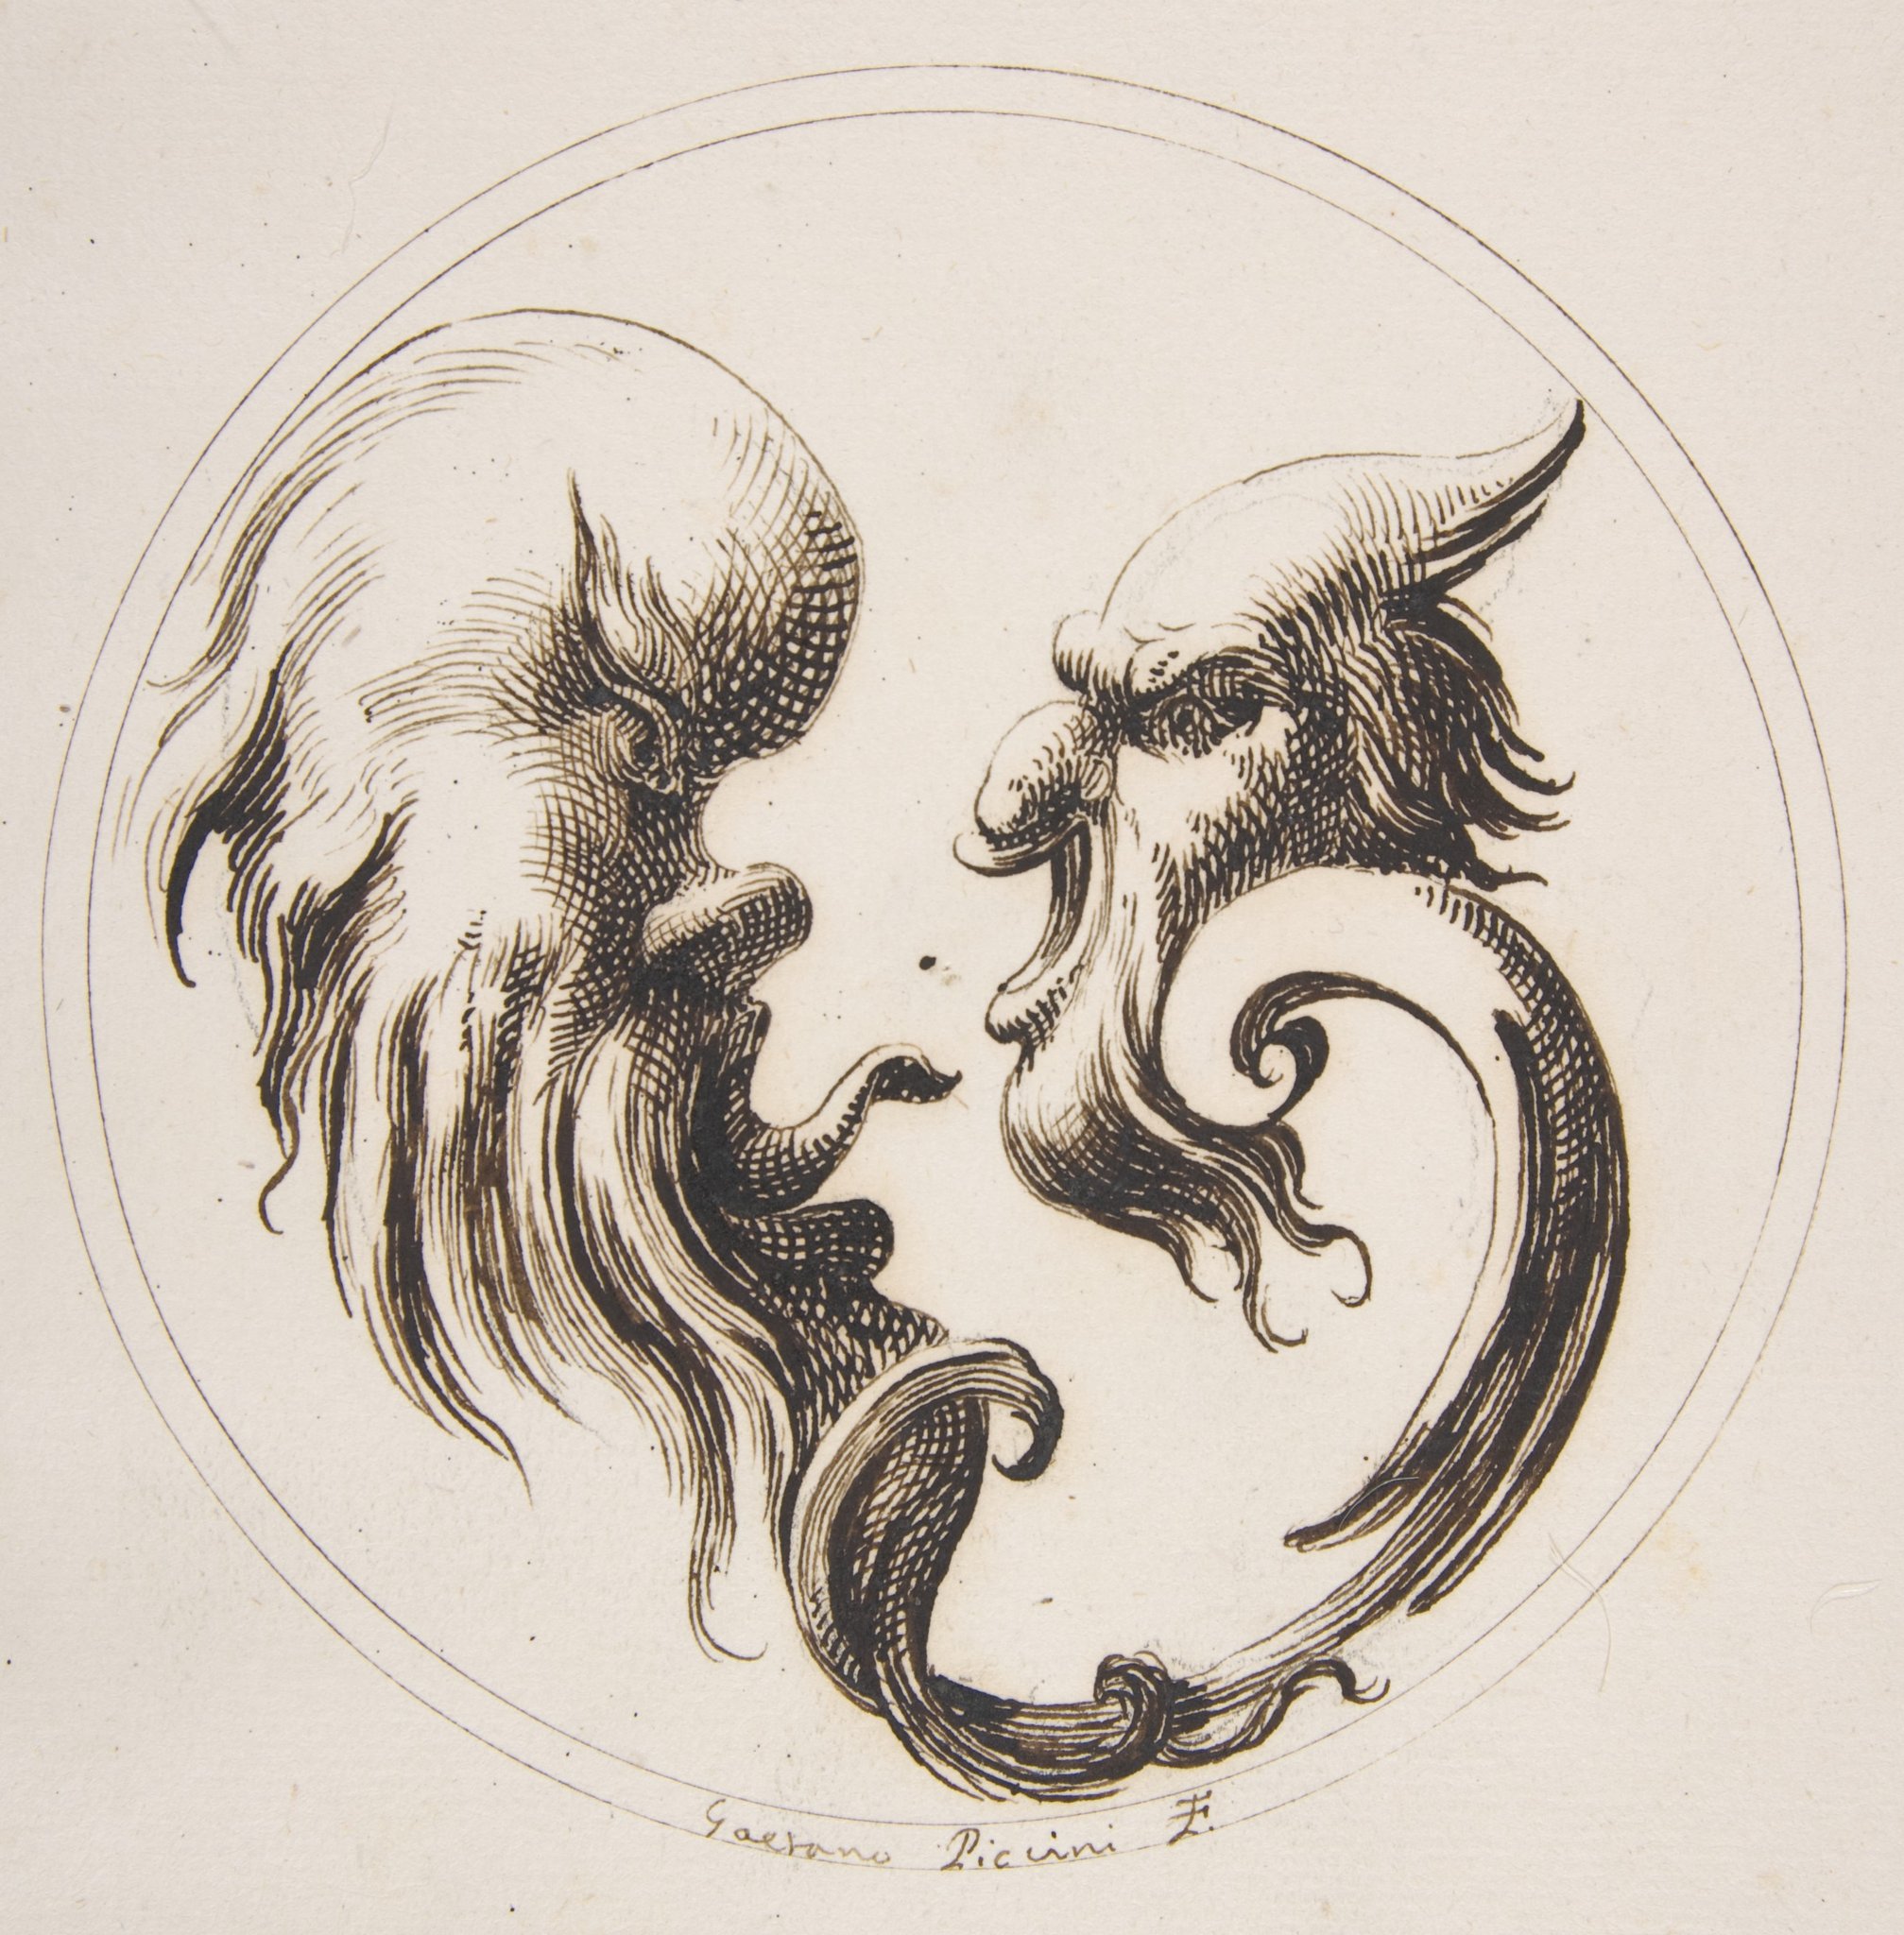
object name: drawing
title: Two Grotesque Heads Facing One Another within a Circle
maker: gaetano piccini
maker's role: artist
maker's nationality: italian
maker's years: 1710-1730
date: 1727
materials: ink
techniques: pen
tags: heads